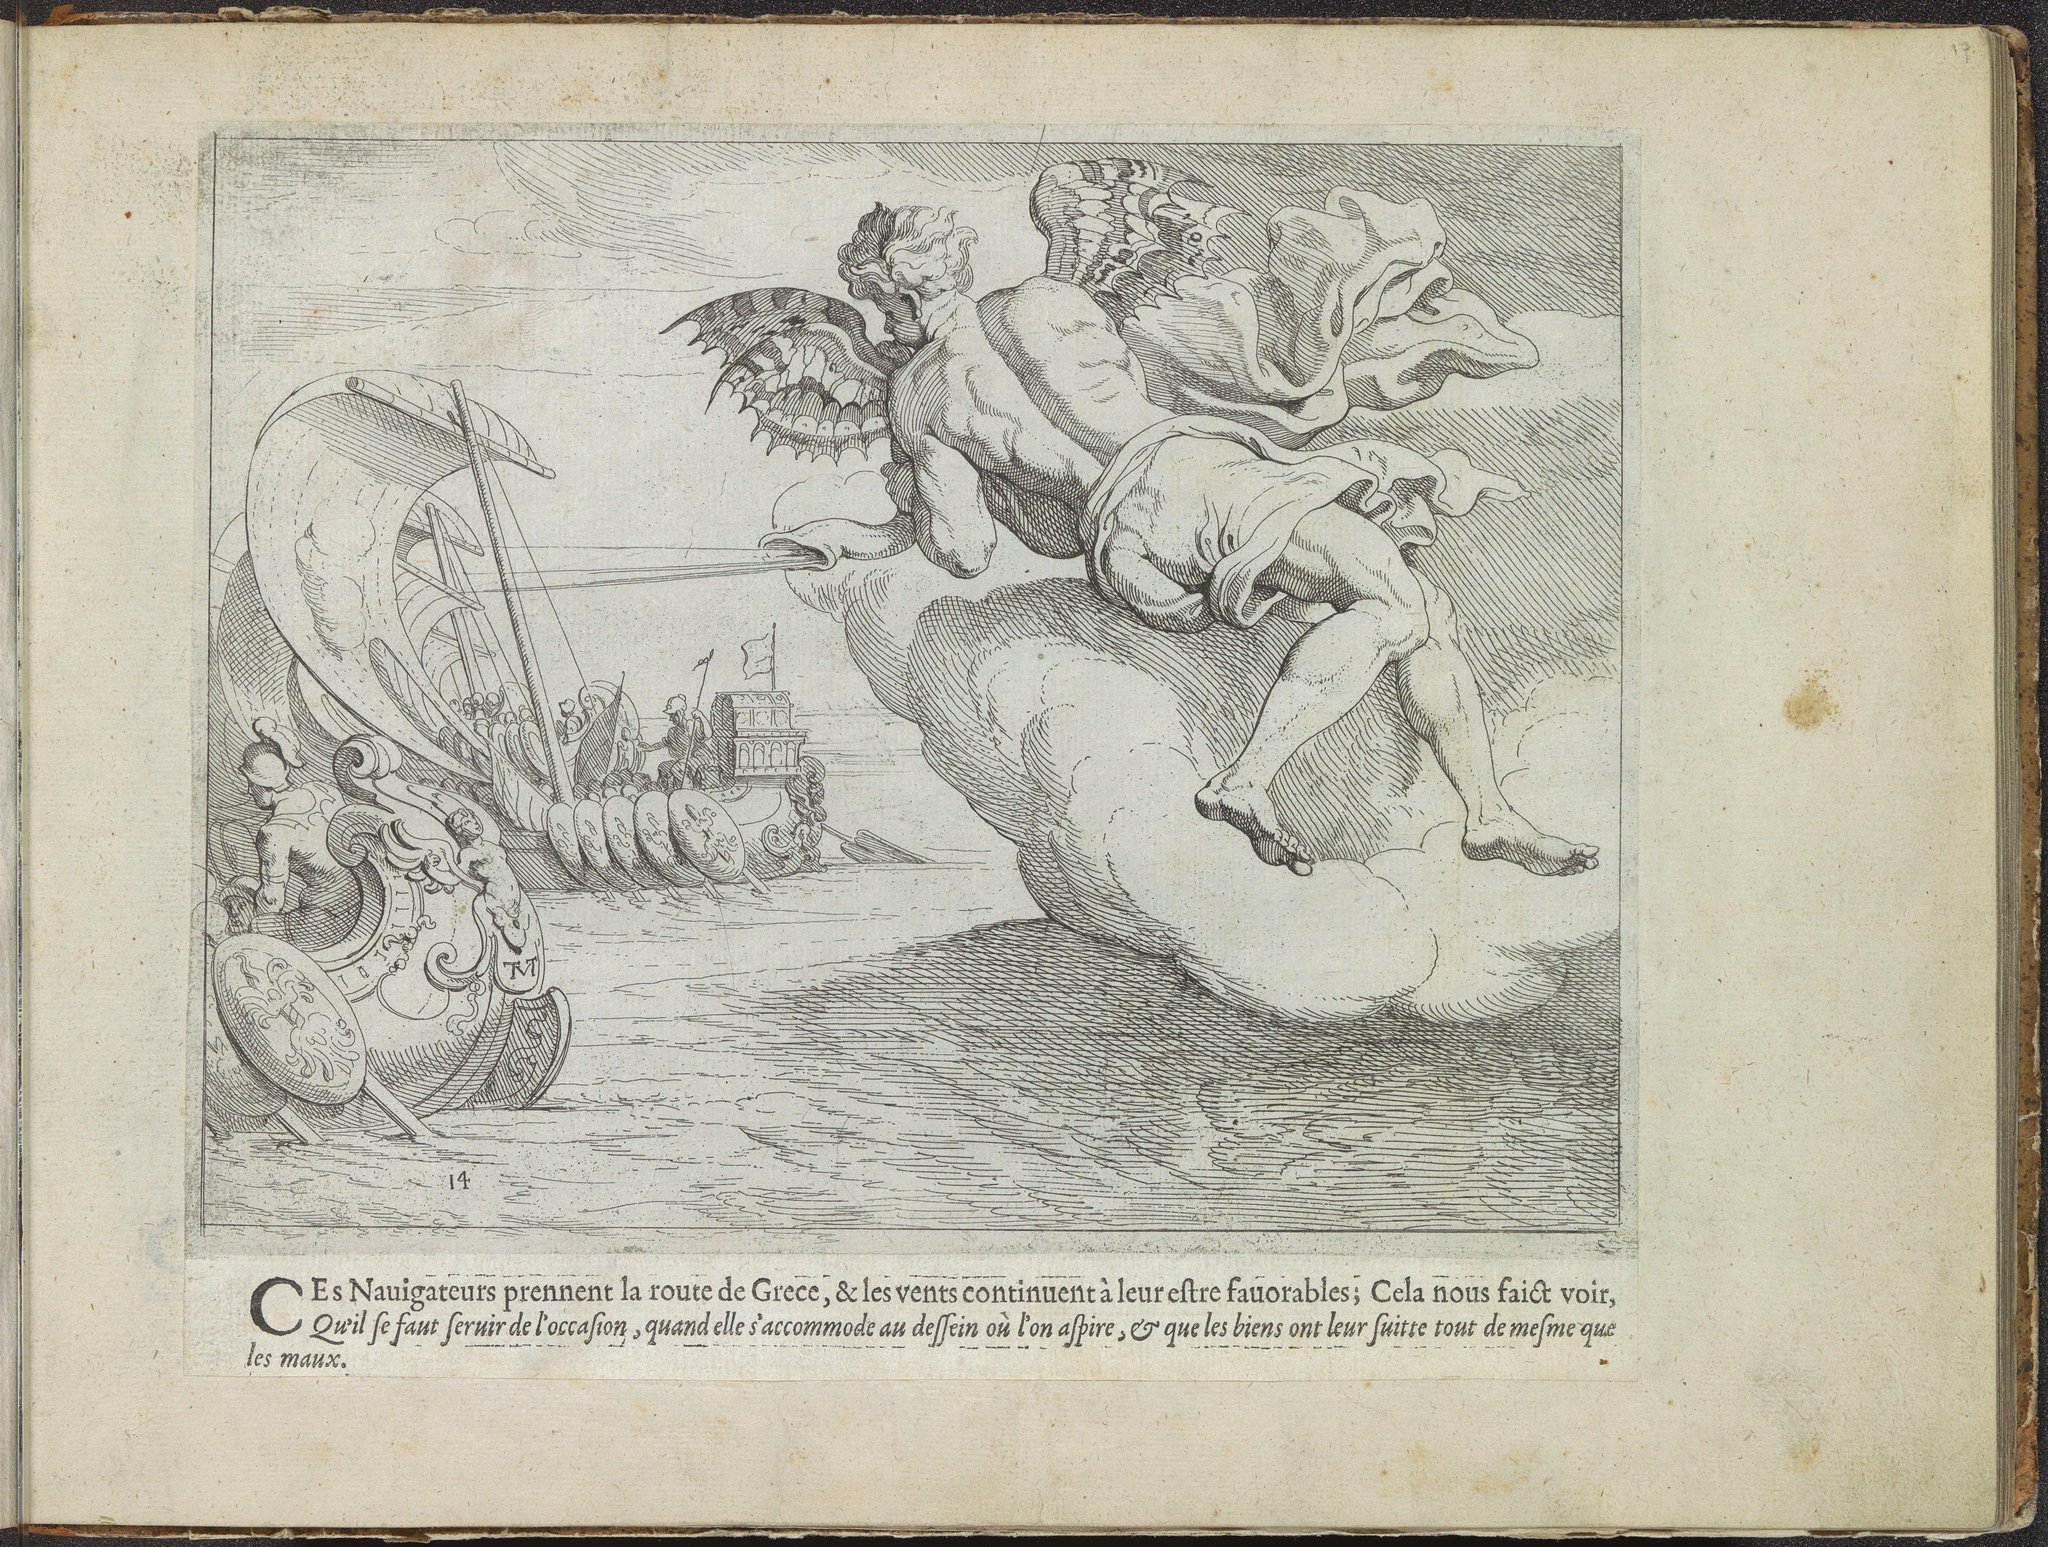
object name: album leaf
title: Les Travaux d'Ulysse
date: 1633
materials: paper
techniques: engraving, etching, letterpress printing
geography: paris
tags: wanderings of ulysses: from the cicones to scylla, (story of) zephyrus (favonius), the west wind; 'favonio o zeffiro' (ripa)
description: Zephyrus, de god van de westenwind, blaast de schepen van Odysseus vooruit. De prent maakt deel uit van een album.